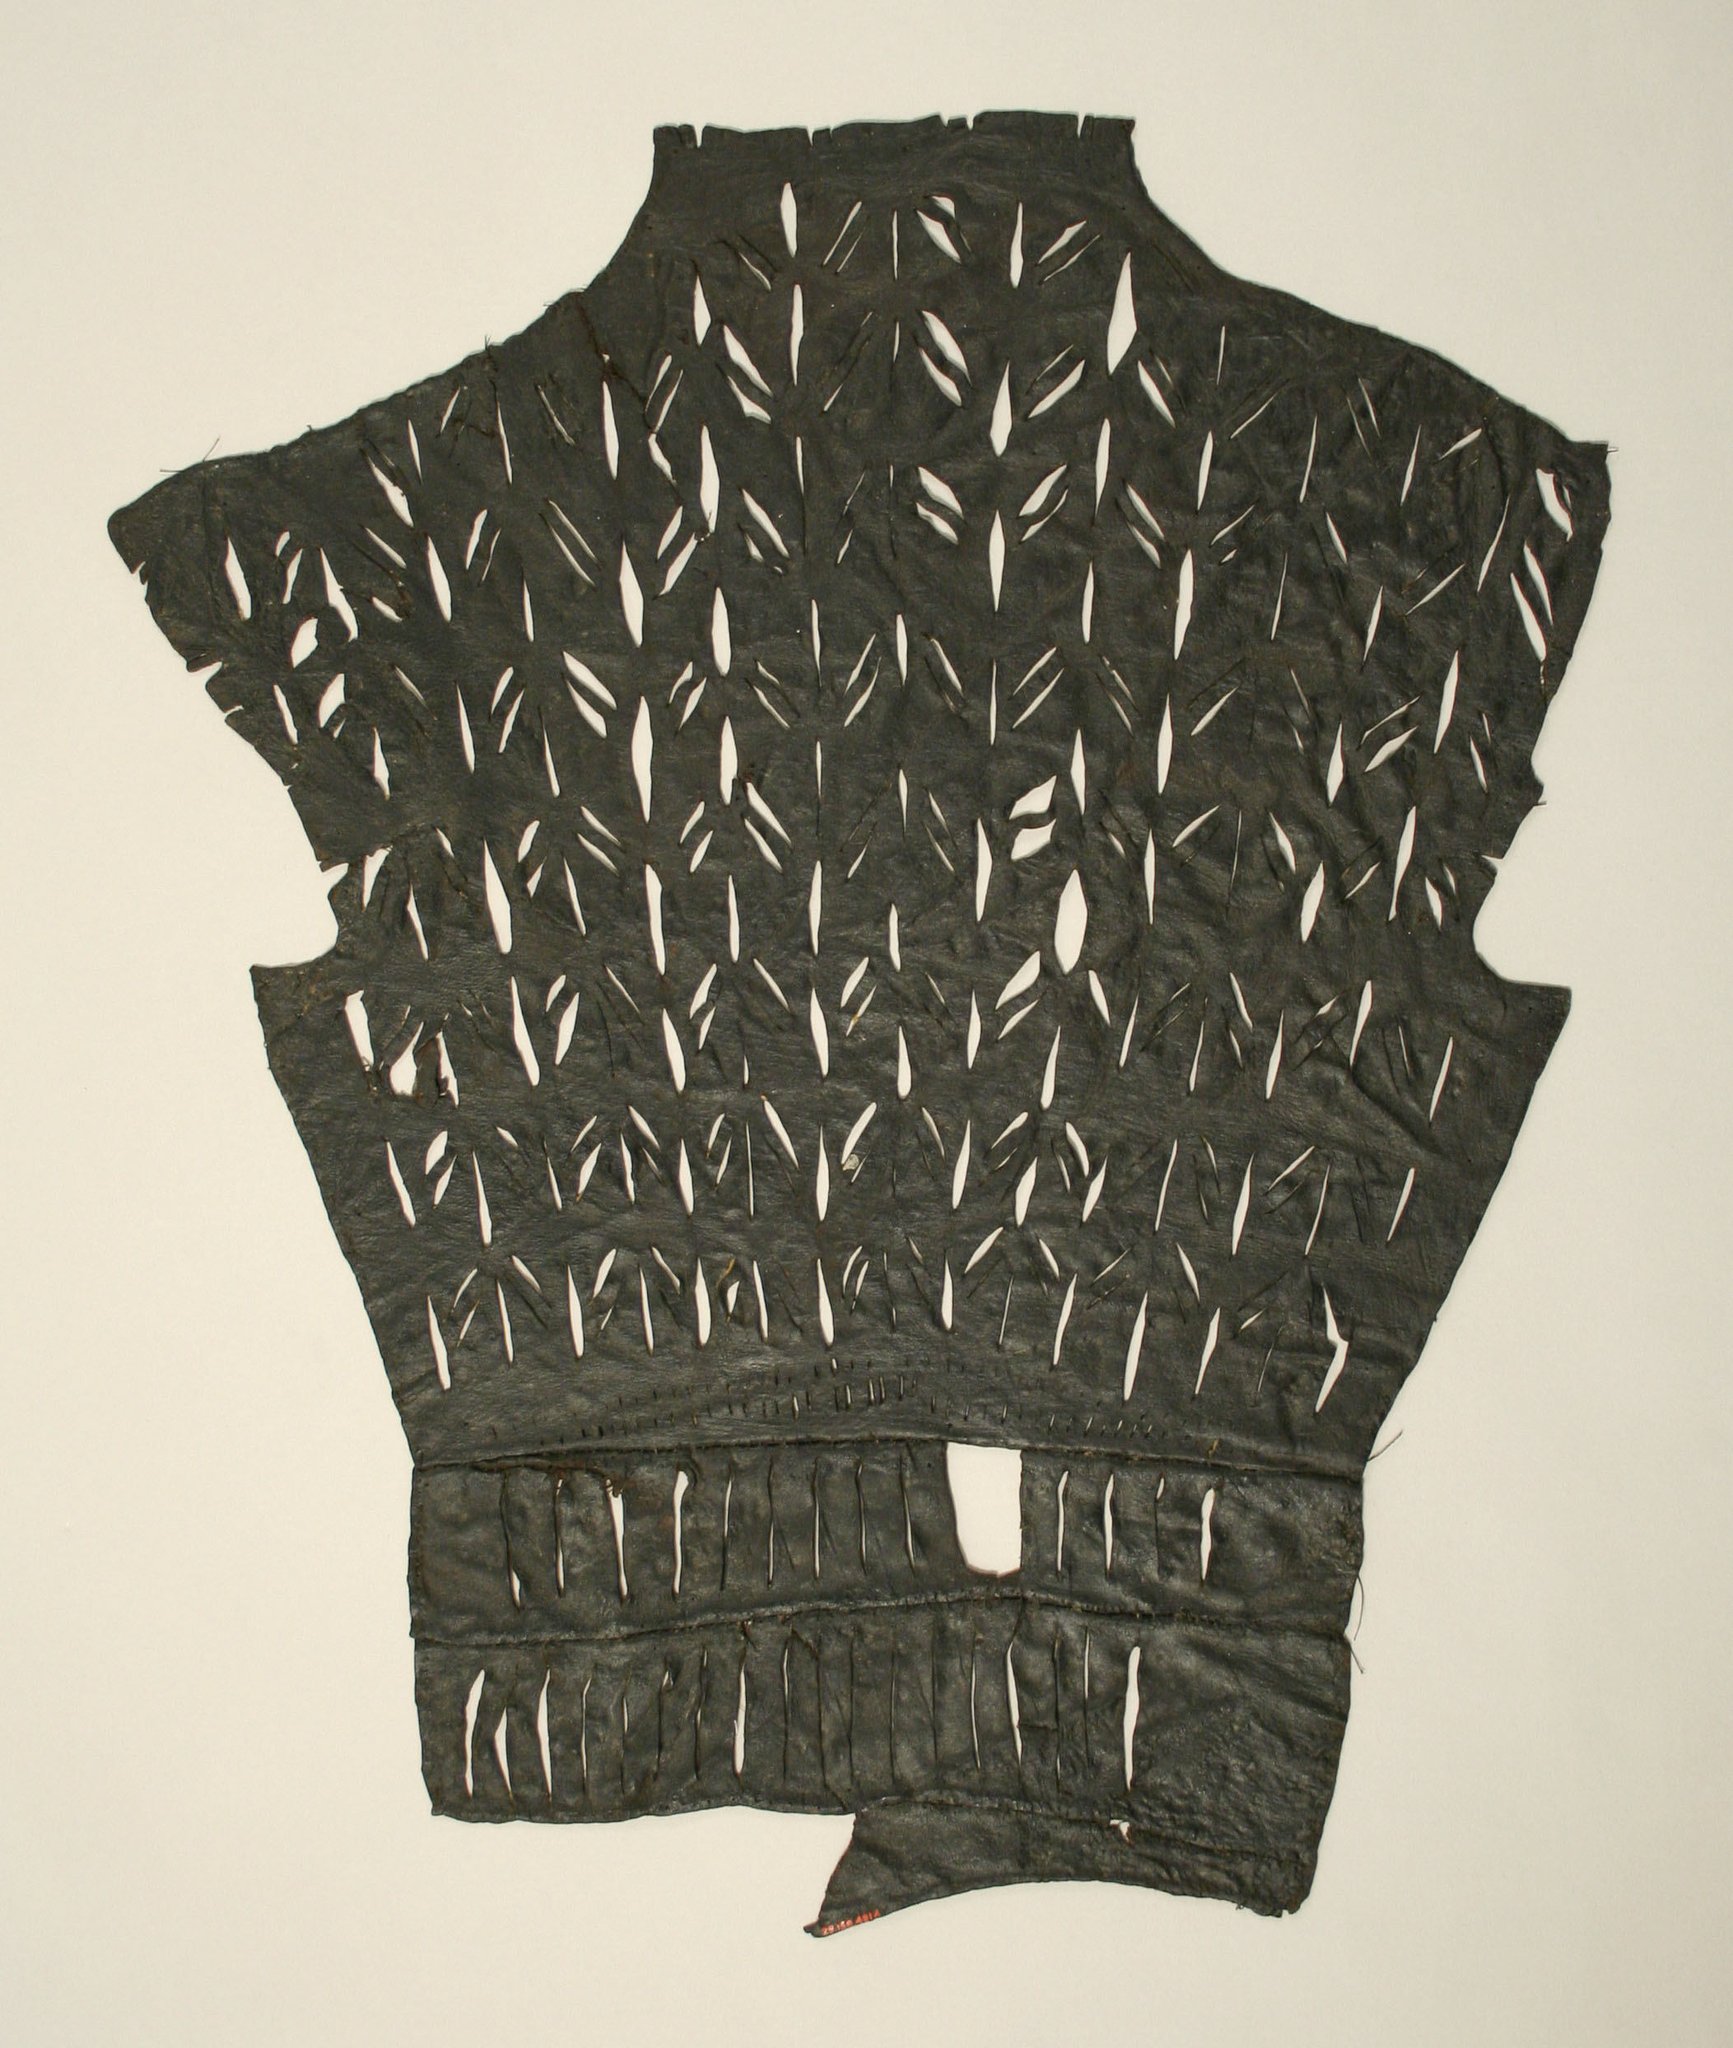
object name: doublet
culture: british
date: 1501-1600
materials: leather